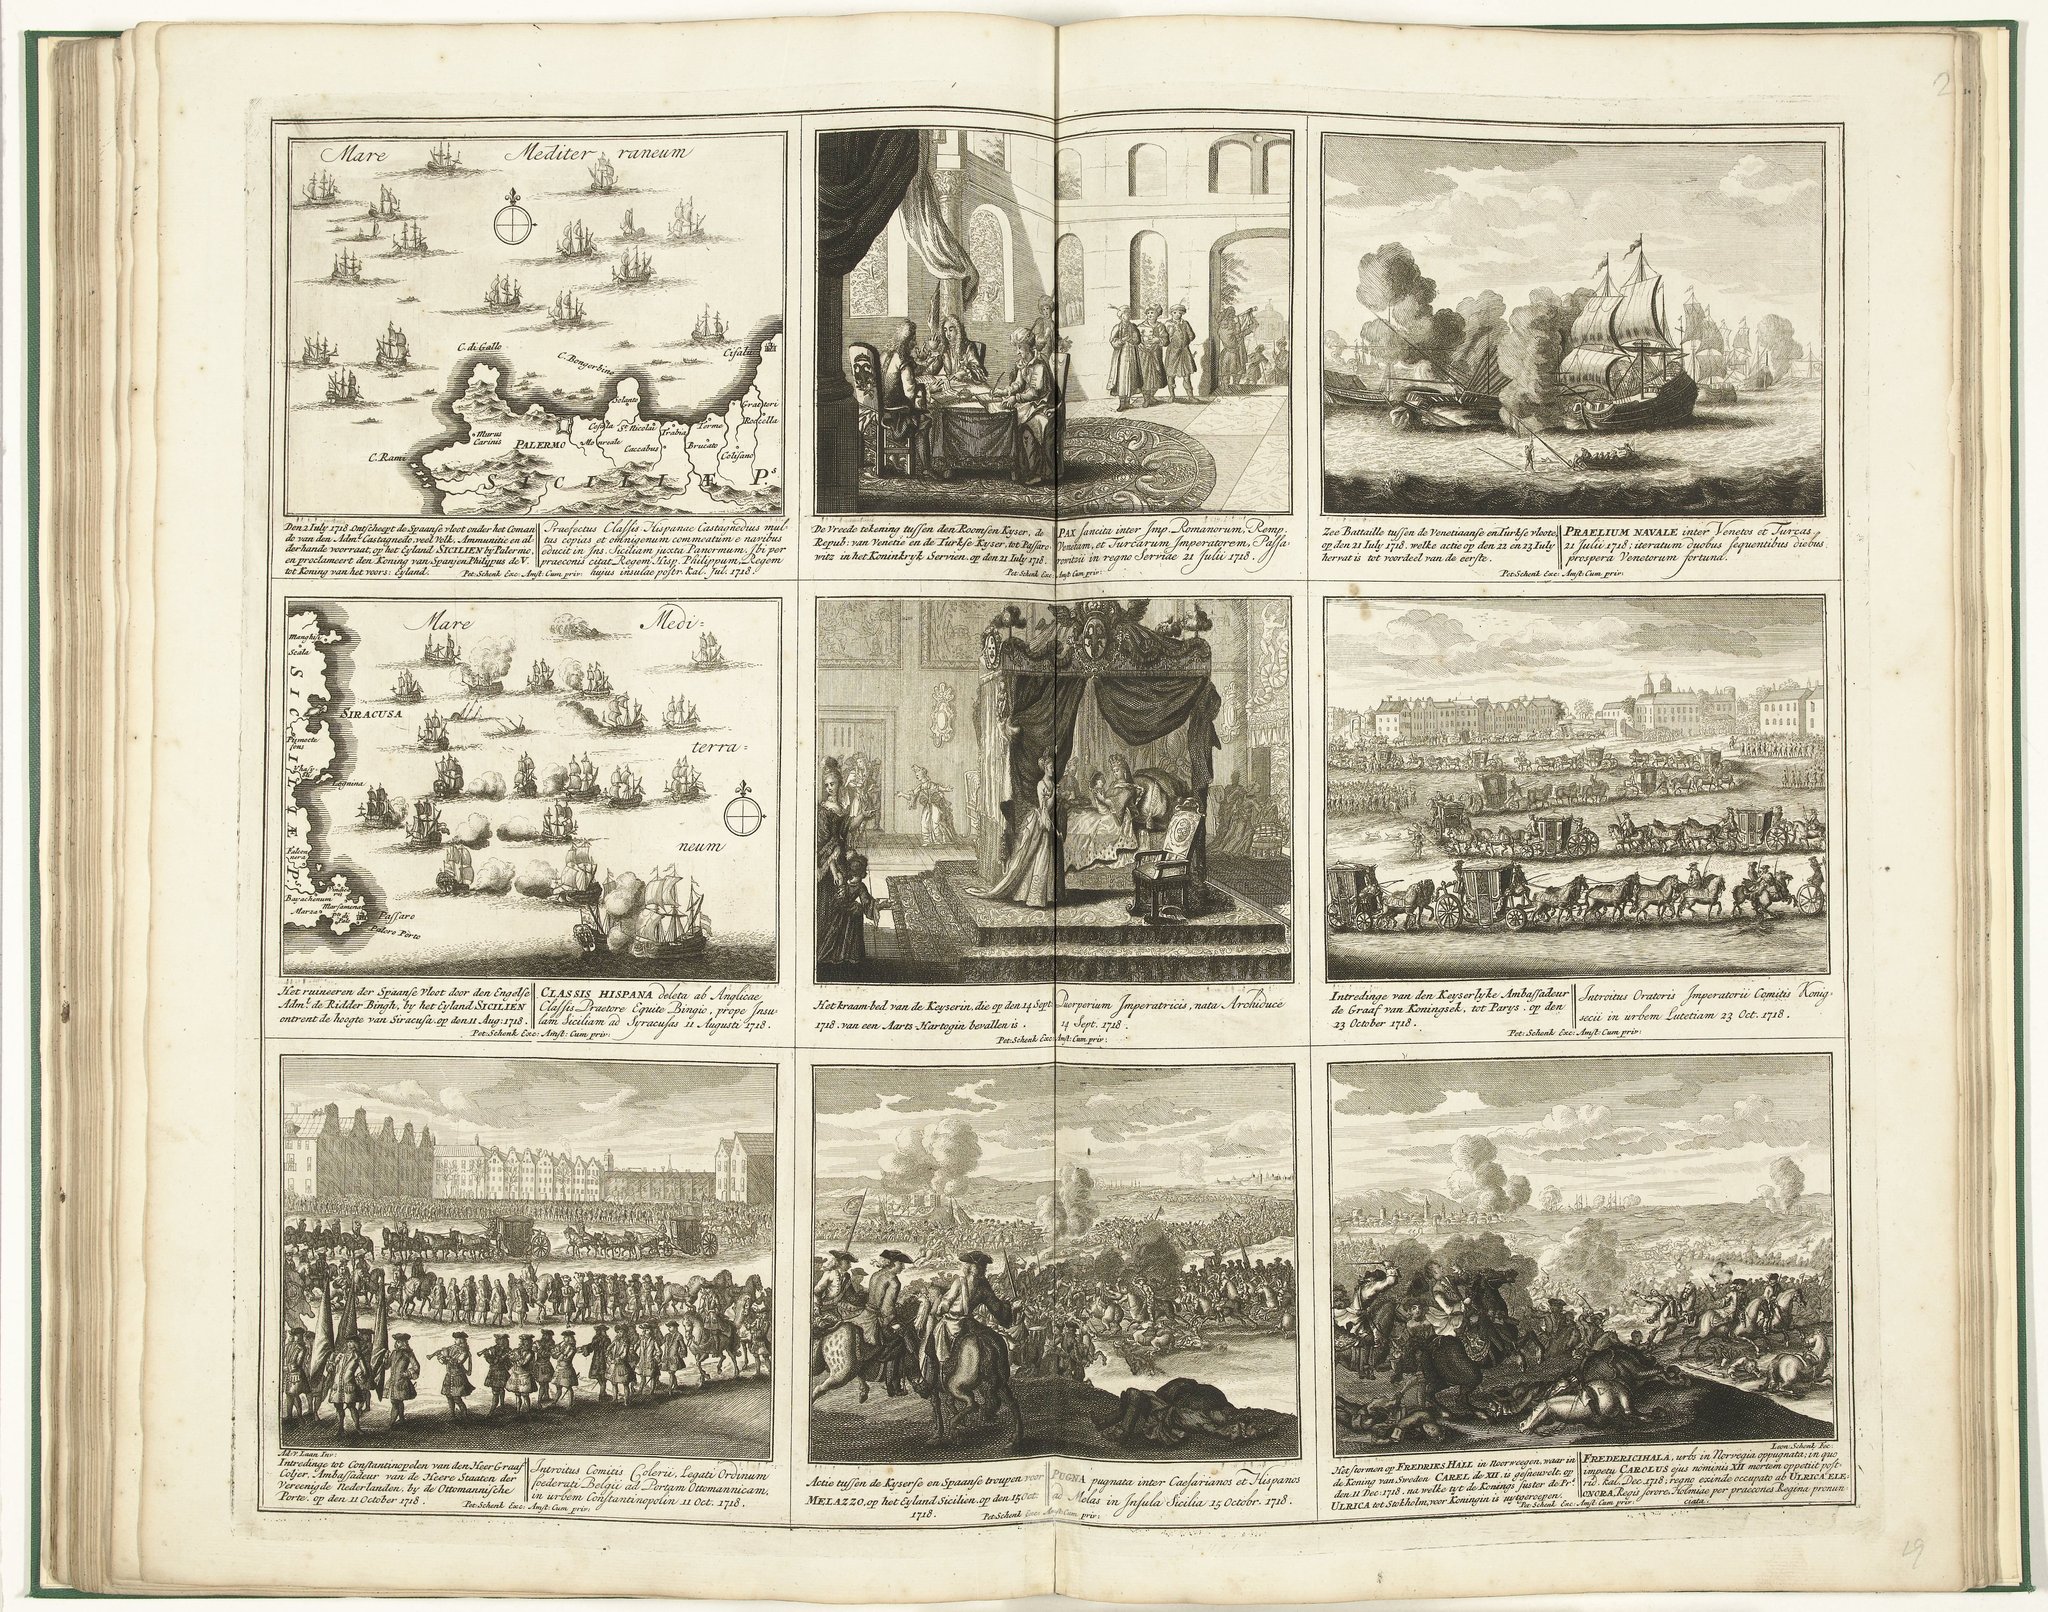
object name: print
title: Schouwburg van den Oorlog, Beginnende van Koning Karel den II. Tot op Koning Karel den III. Bestaande in IX. Historische Figuren op een Olifants Blad, als Veldslagen, Belegeringen te Water en te Lande, met de voornaamste Vestingen (...)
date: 1718-1720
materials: paper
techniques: etching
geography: northern netherlands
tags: maps of separate countries or regions, battle (+ naval force), signing of peace treaty, concluding the peace, lying-in room, battle (+ land forces), paris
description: Blad met negen voorstellingen van gebeurtenissen uit het jaar 1718 in de oorlog tegen de Turken (1716-1718) en in de Spaanse Successieoorlog. Blad XIX in: Schouwburg van den oorlog (editie van 1720), het prentwerk met de gebundelde reeks van 31 platen over de Spaanse Successieoorlog.